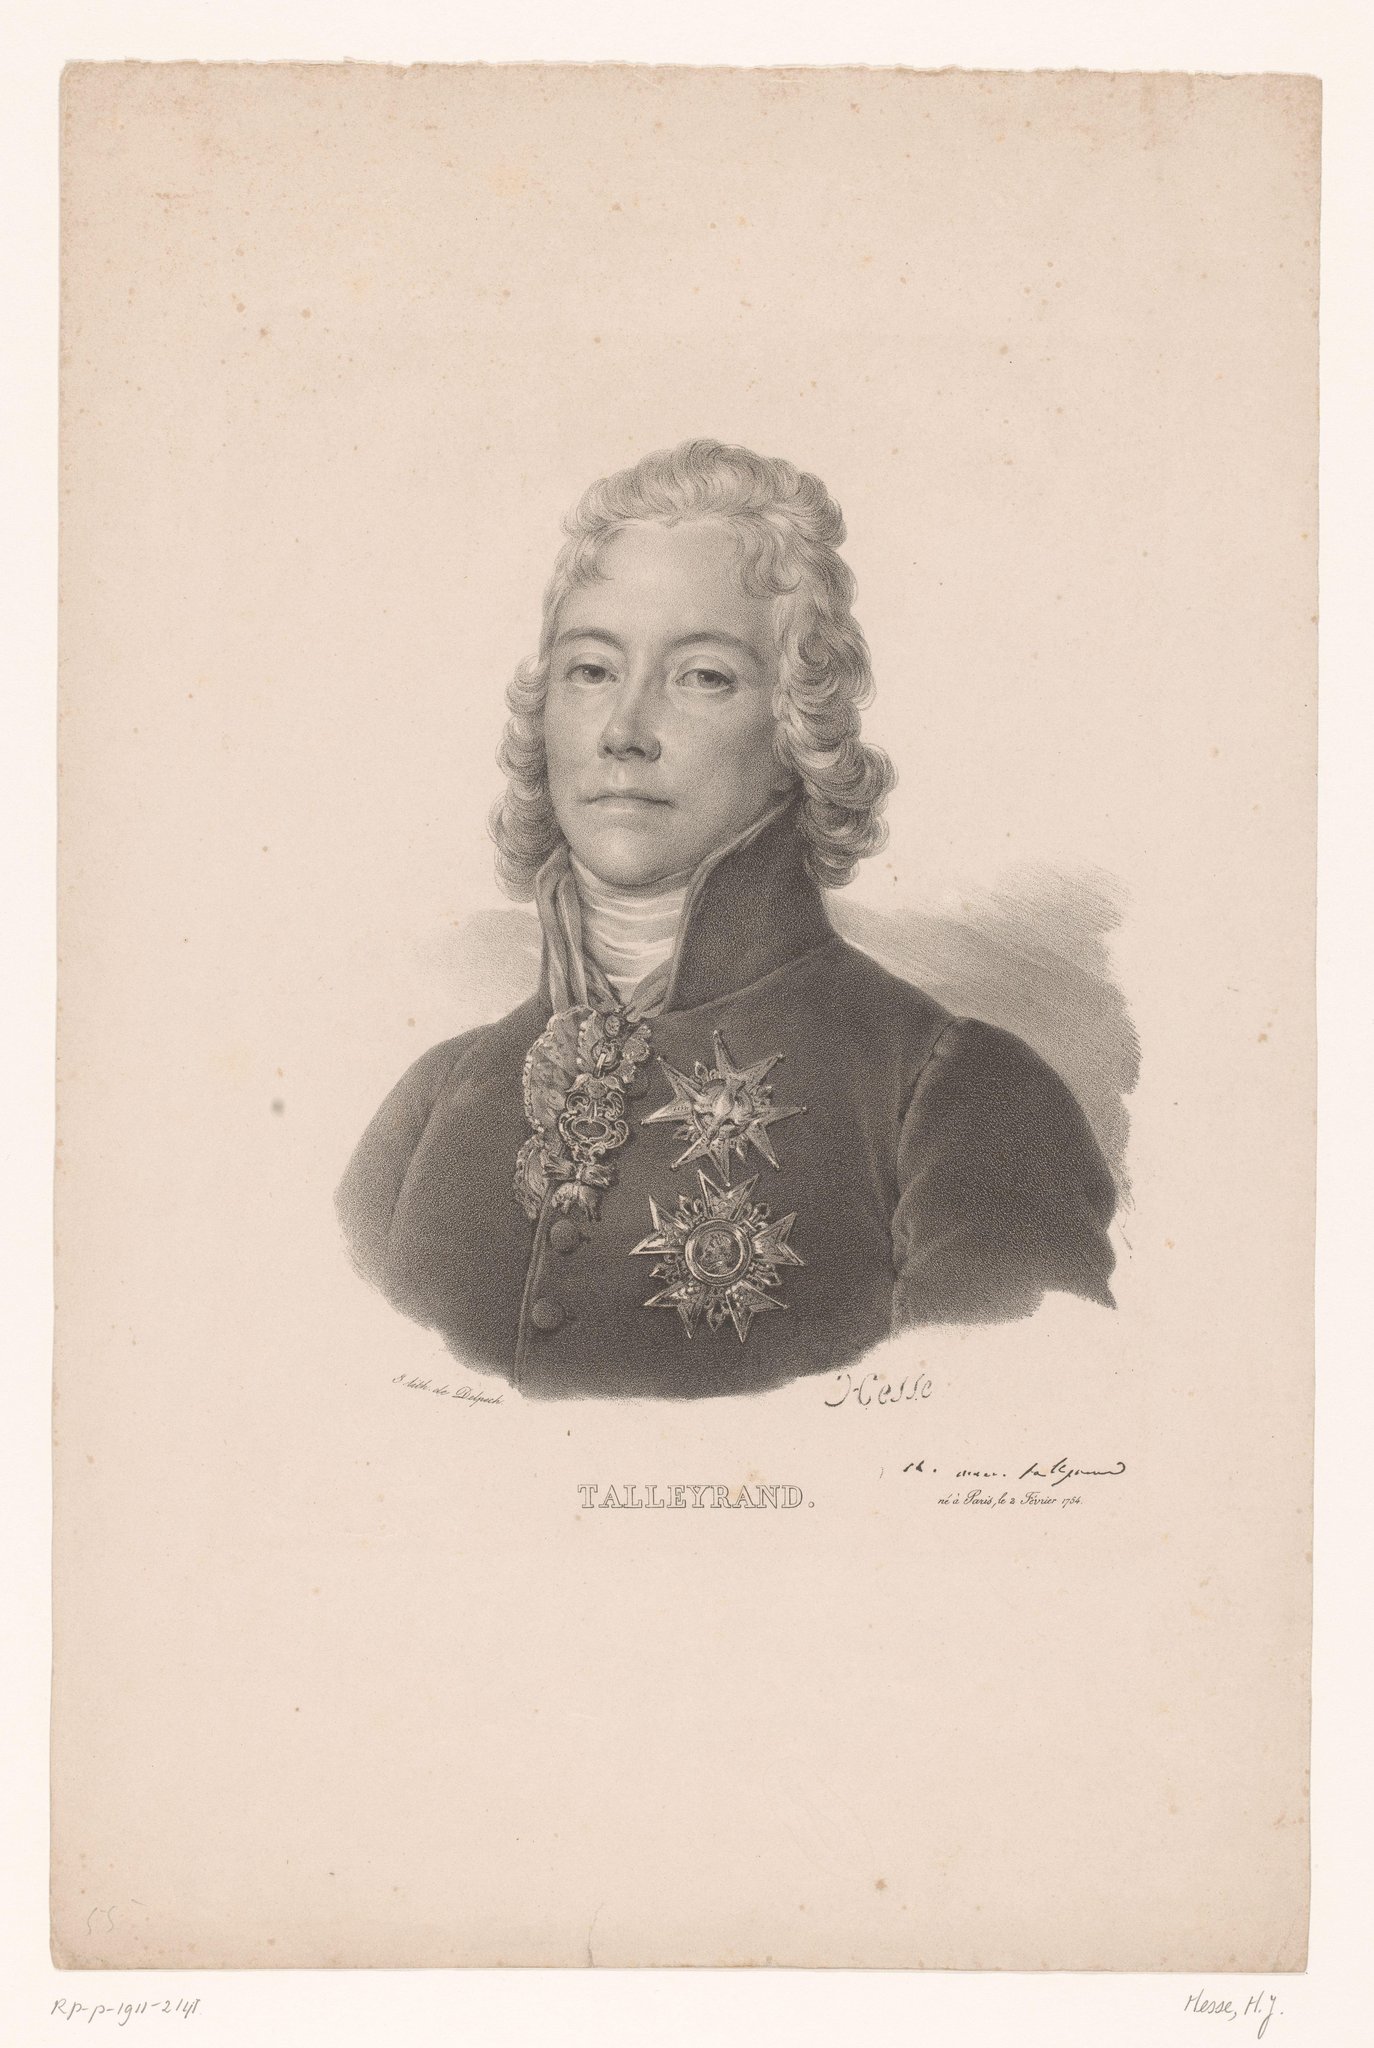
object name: print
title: Talleyrand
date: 1823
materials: paper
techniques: lithograph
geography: paris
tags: paris, politician, charles maurice hertog van talleyrand-périgord, historical persons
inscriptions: collector's mark: Lugt 2228a